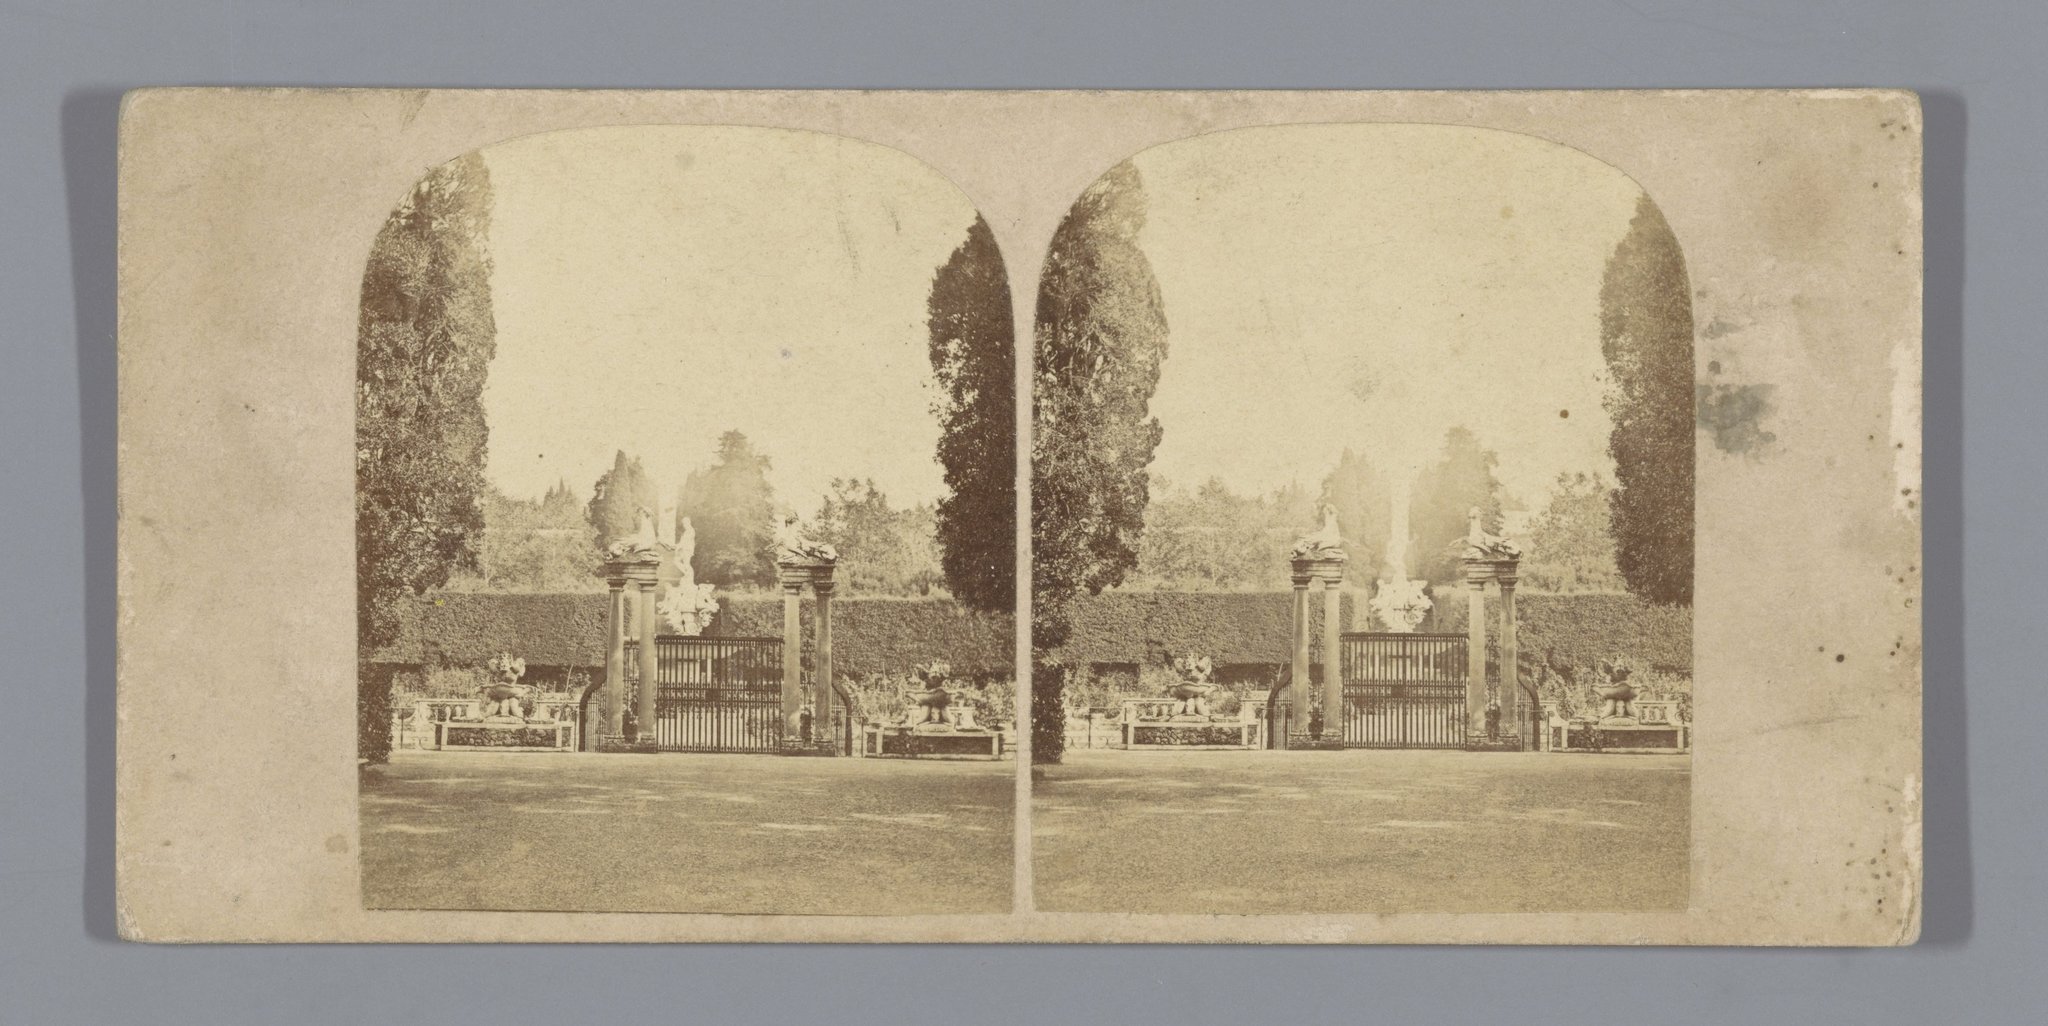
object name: stereograph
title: Gezicht op de Giardino di Boboli in Florence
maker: Anonymous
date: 1850-1880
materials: cardboard, photographic support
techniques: albumen print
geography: florence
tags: public gardens, park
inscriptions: number: ‘110 No.1.’